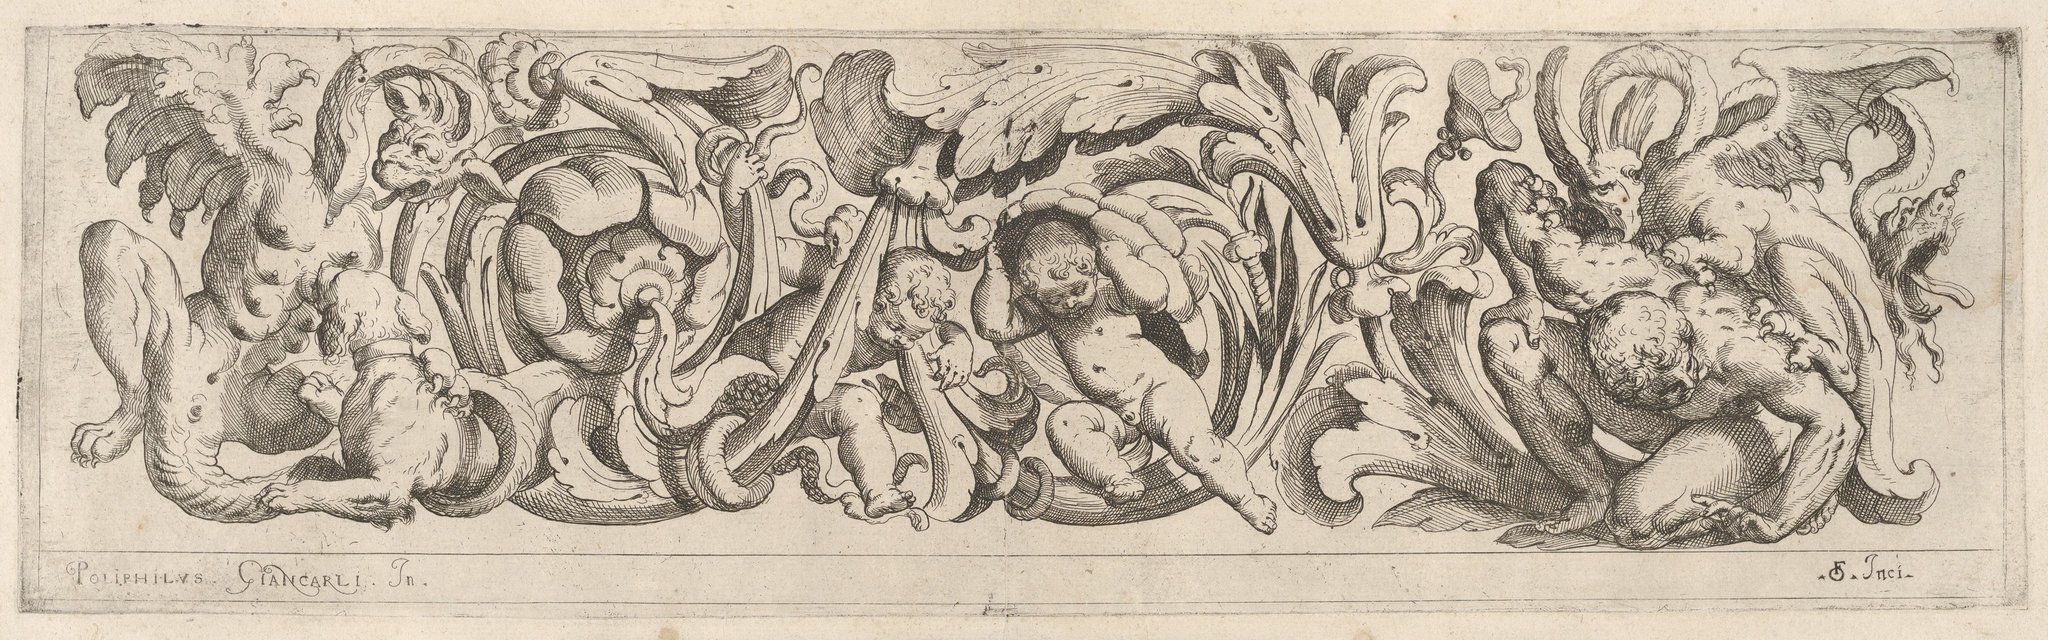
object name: collection ornament architecture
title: Disegni Varij di Polifilo Zancarli (Friezes)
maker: polifilo giancarli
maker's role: artist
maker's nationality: italian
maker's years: 1600-1625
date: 1625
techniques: etching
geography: italy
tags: ornament,dragons,putti,dogs